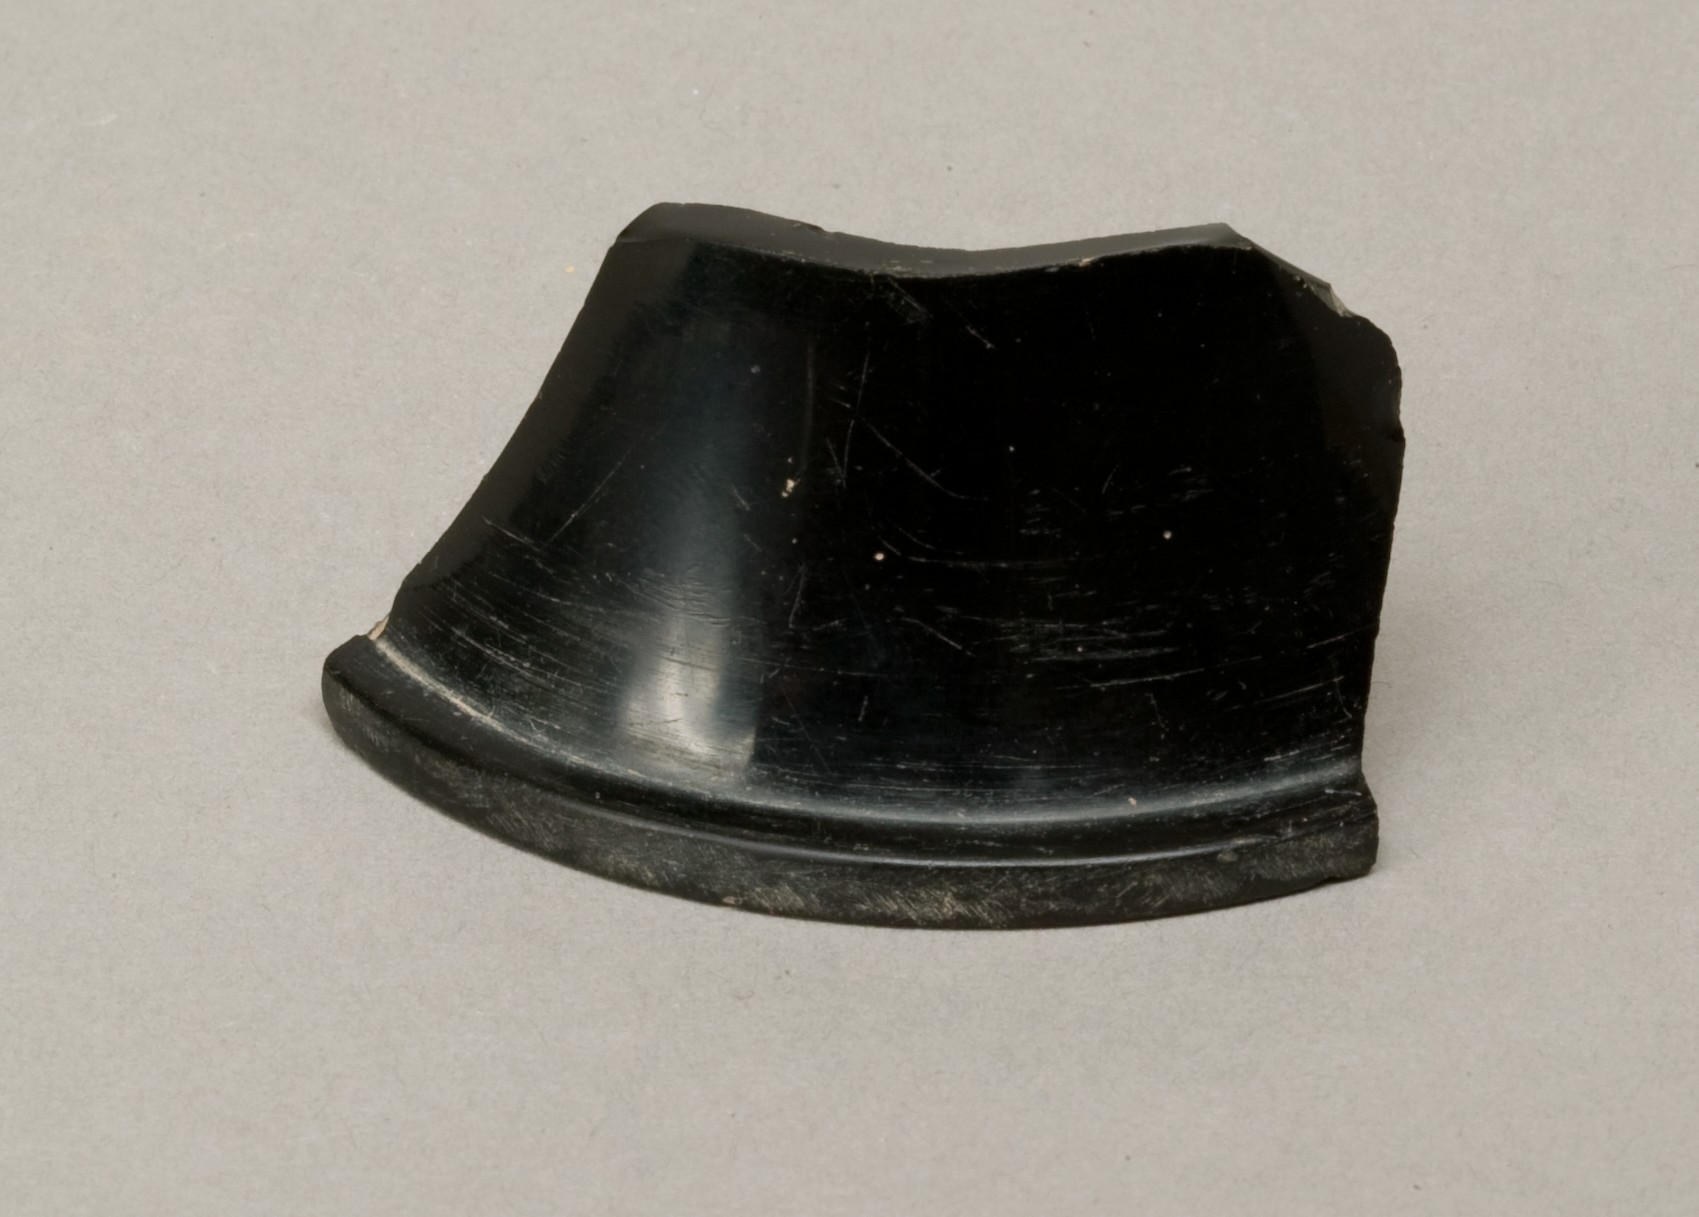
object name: vase, rim fragment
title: Rim fragment of ointment vase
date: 1802-1450 BCE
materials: obsidian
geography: egypt